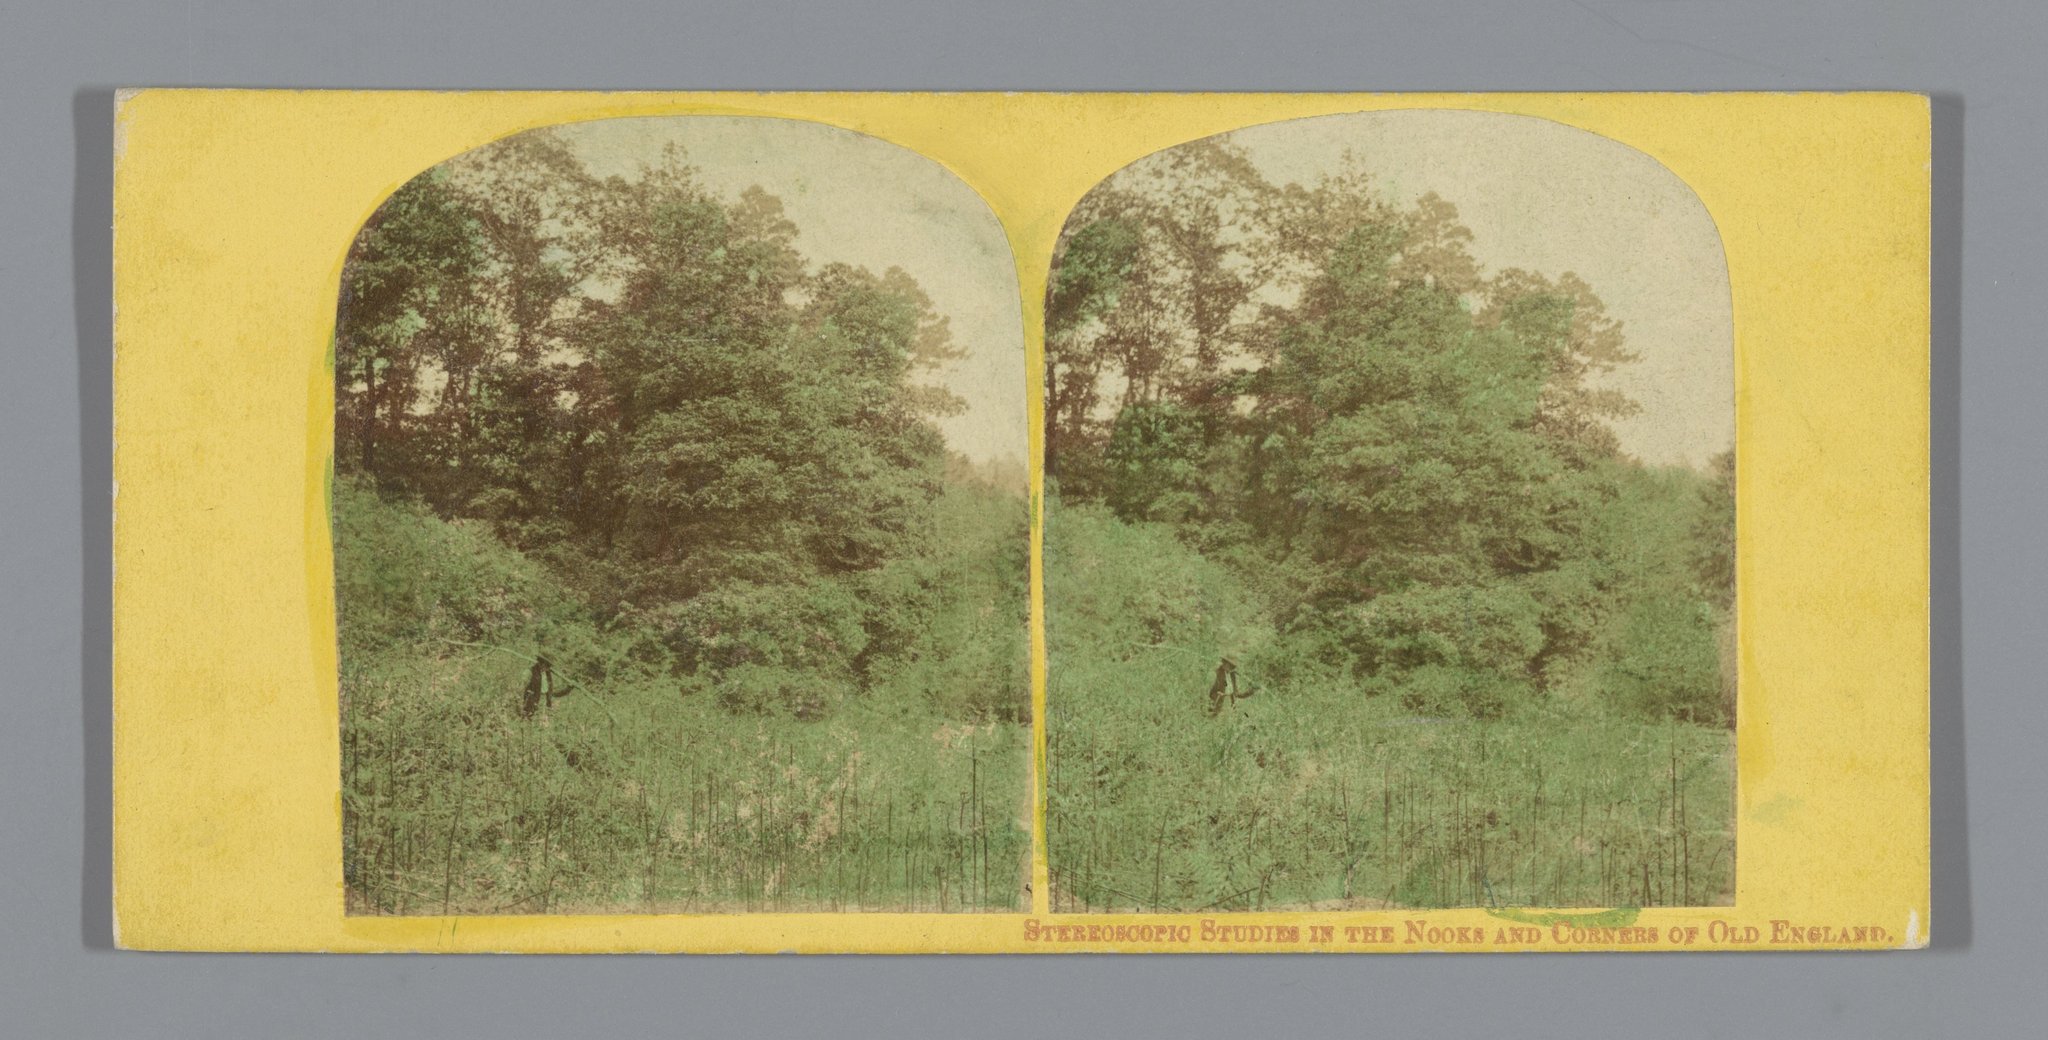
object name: stereograph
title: Boslandschap met een man in Engeland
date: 1854-1880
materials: cardboard, photographic support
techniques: albumen print, hand coloring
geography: england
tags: forest, wood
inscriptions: name